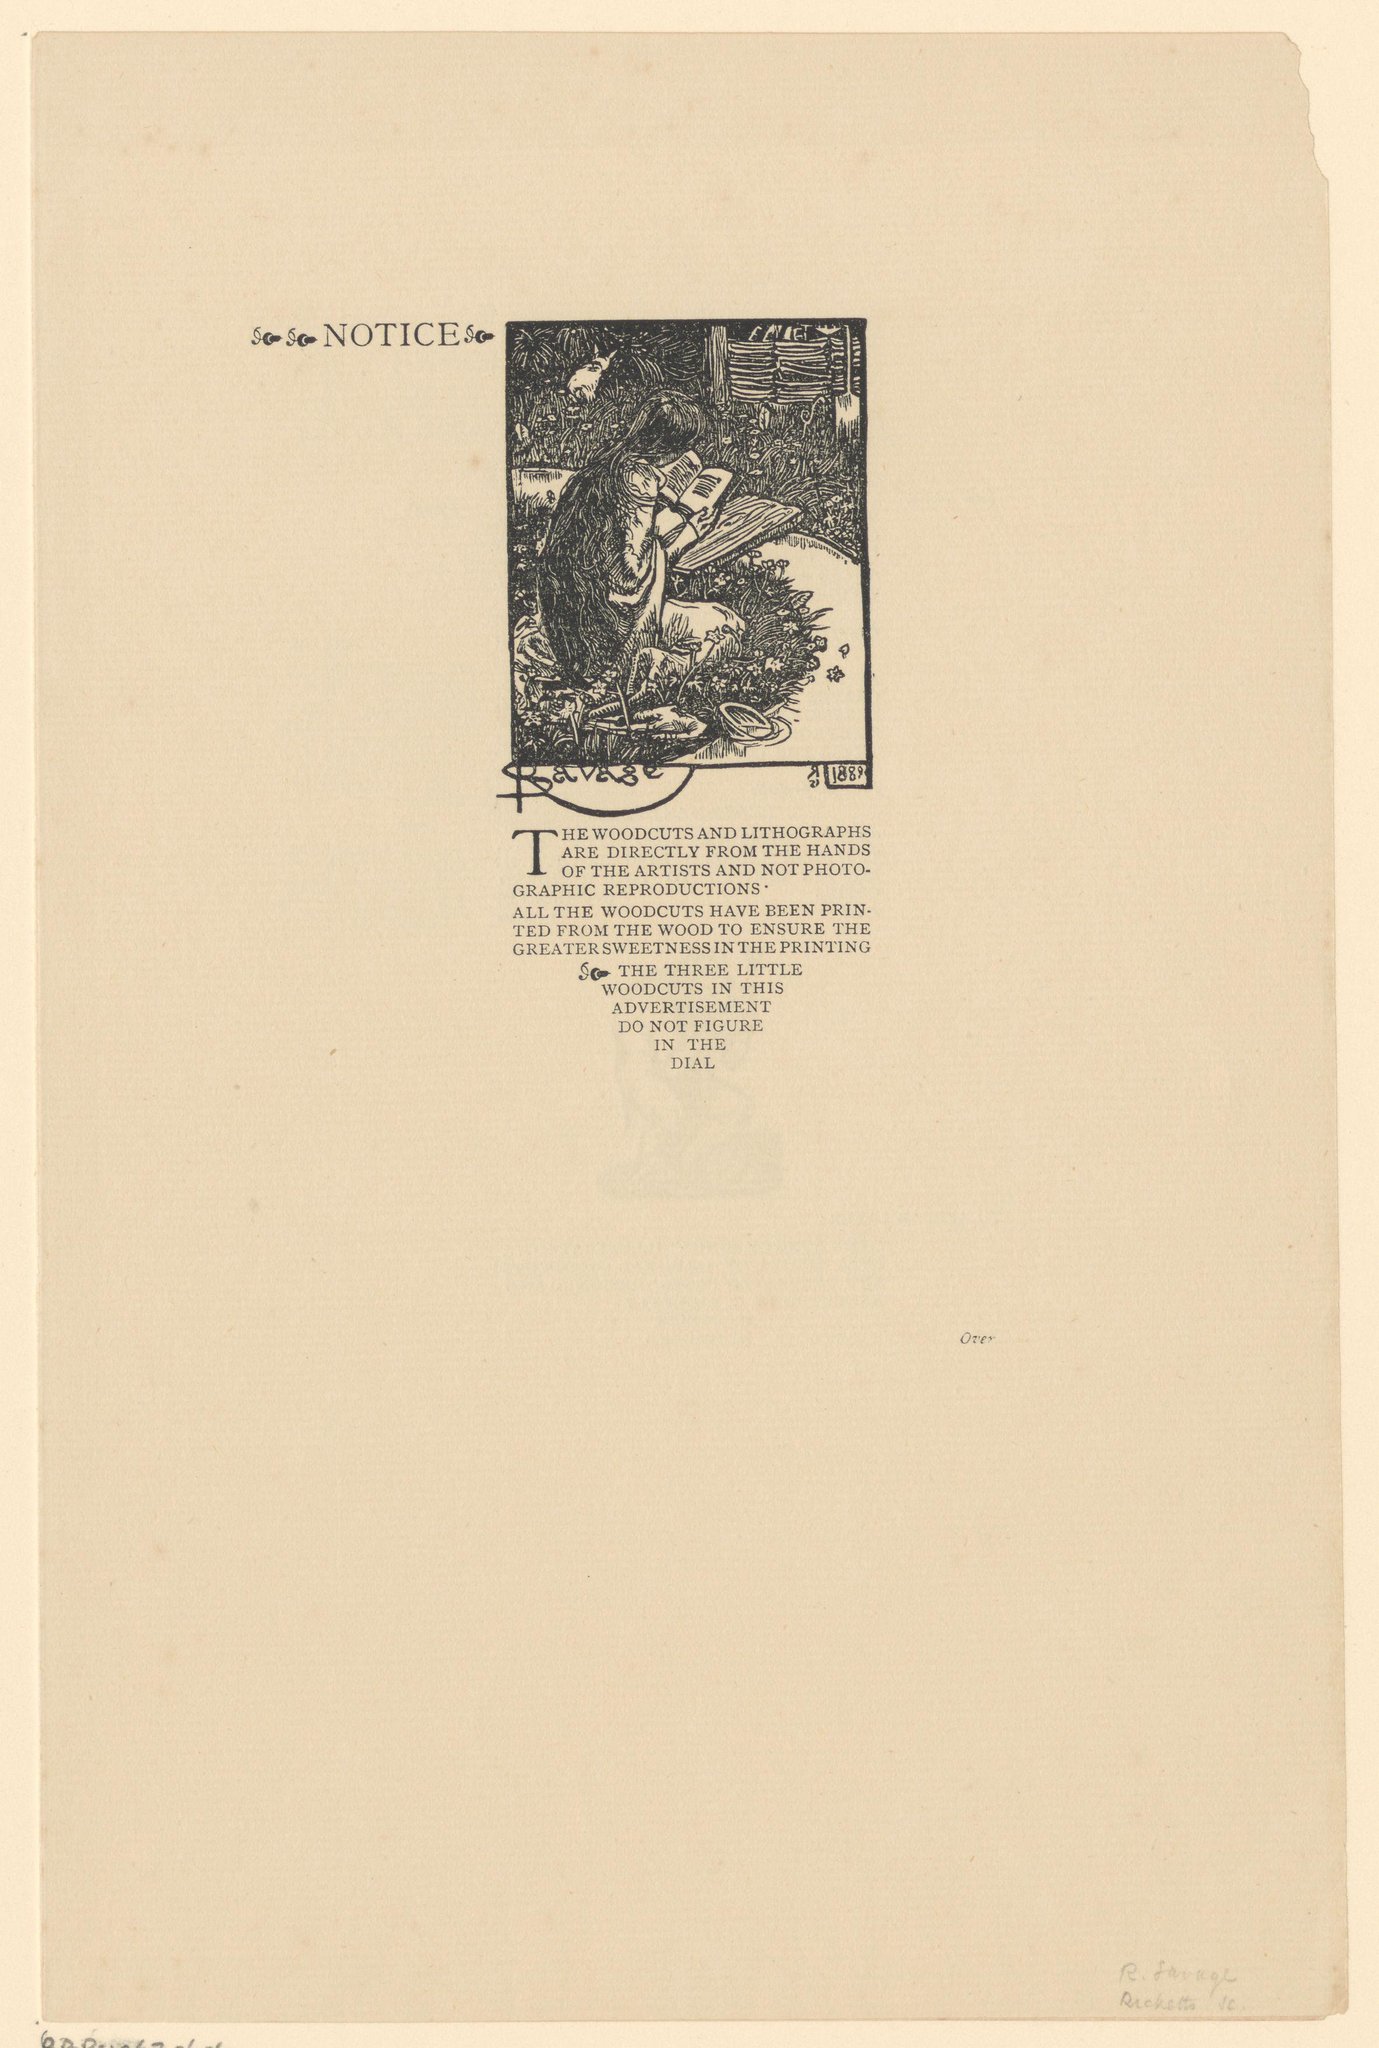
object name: advertisement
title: Lezende vrouw, sater met panfluit en vrouw met muziekinstrument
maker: reginald savage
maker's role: painter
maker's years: 1862-1932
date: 1892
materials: paper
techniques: letterpress printing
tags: musical instruments; group of musical instruments, reading, satyr(s) (in general)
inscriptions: collector's mark: Lugt 2228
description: Advertentie voor uitgaven van 'The Dial'. Deze houtsneden verschenen niet in The Dial zelf.